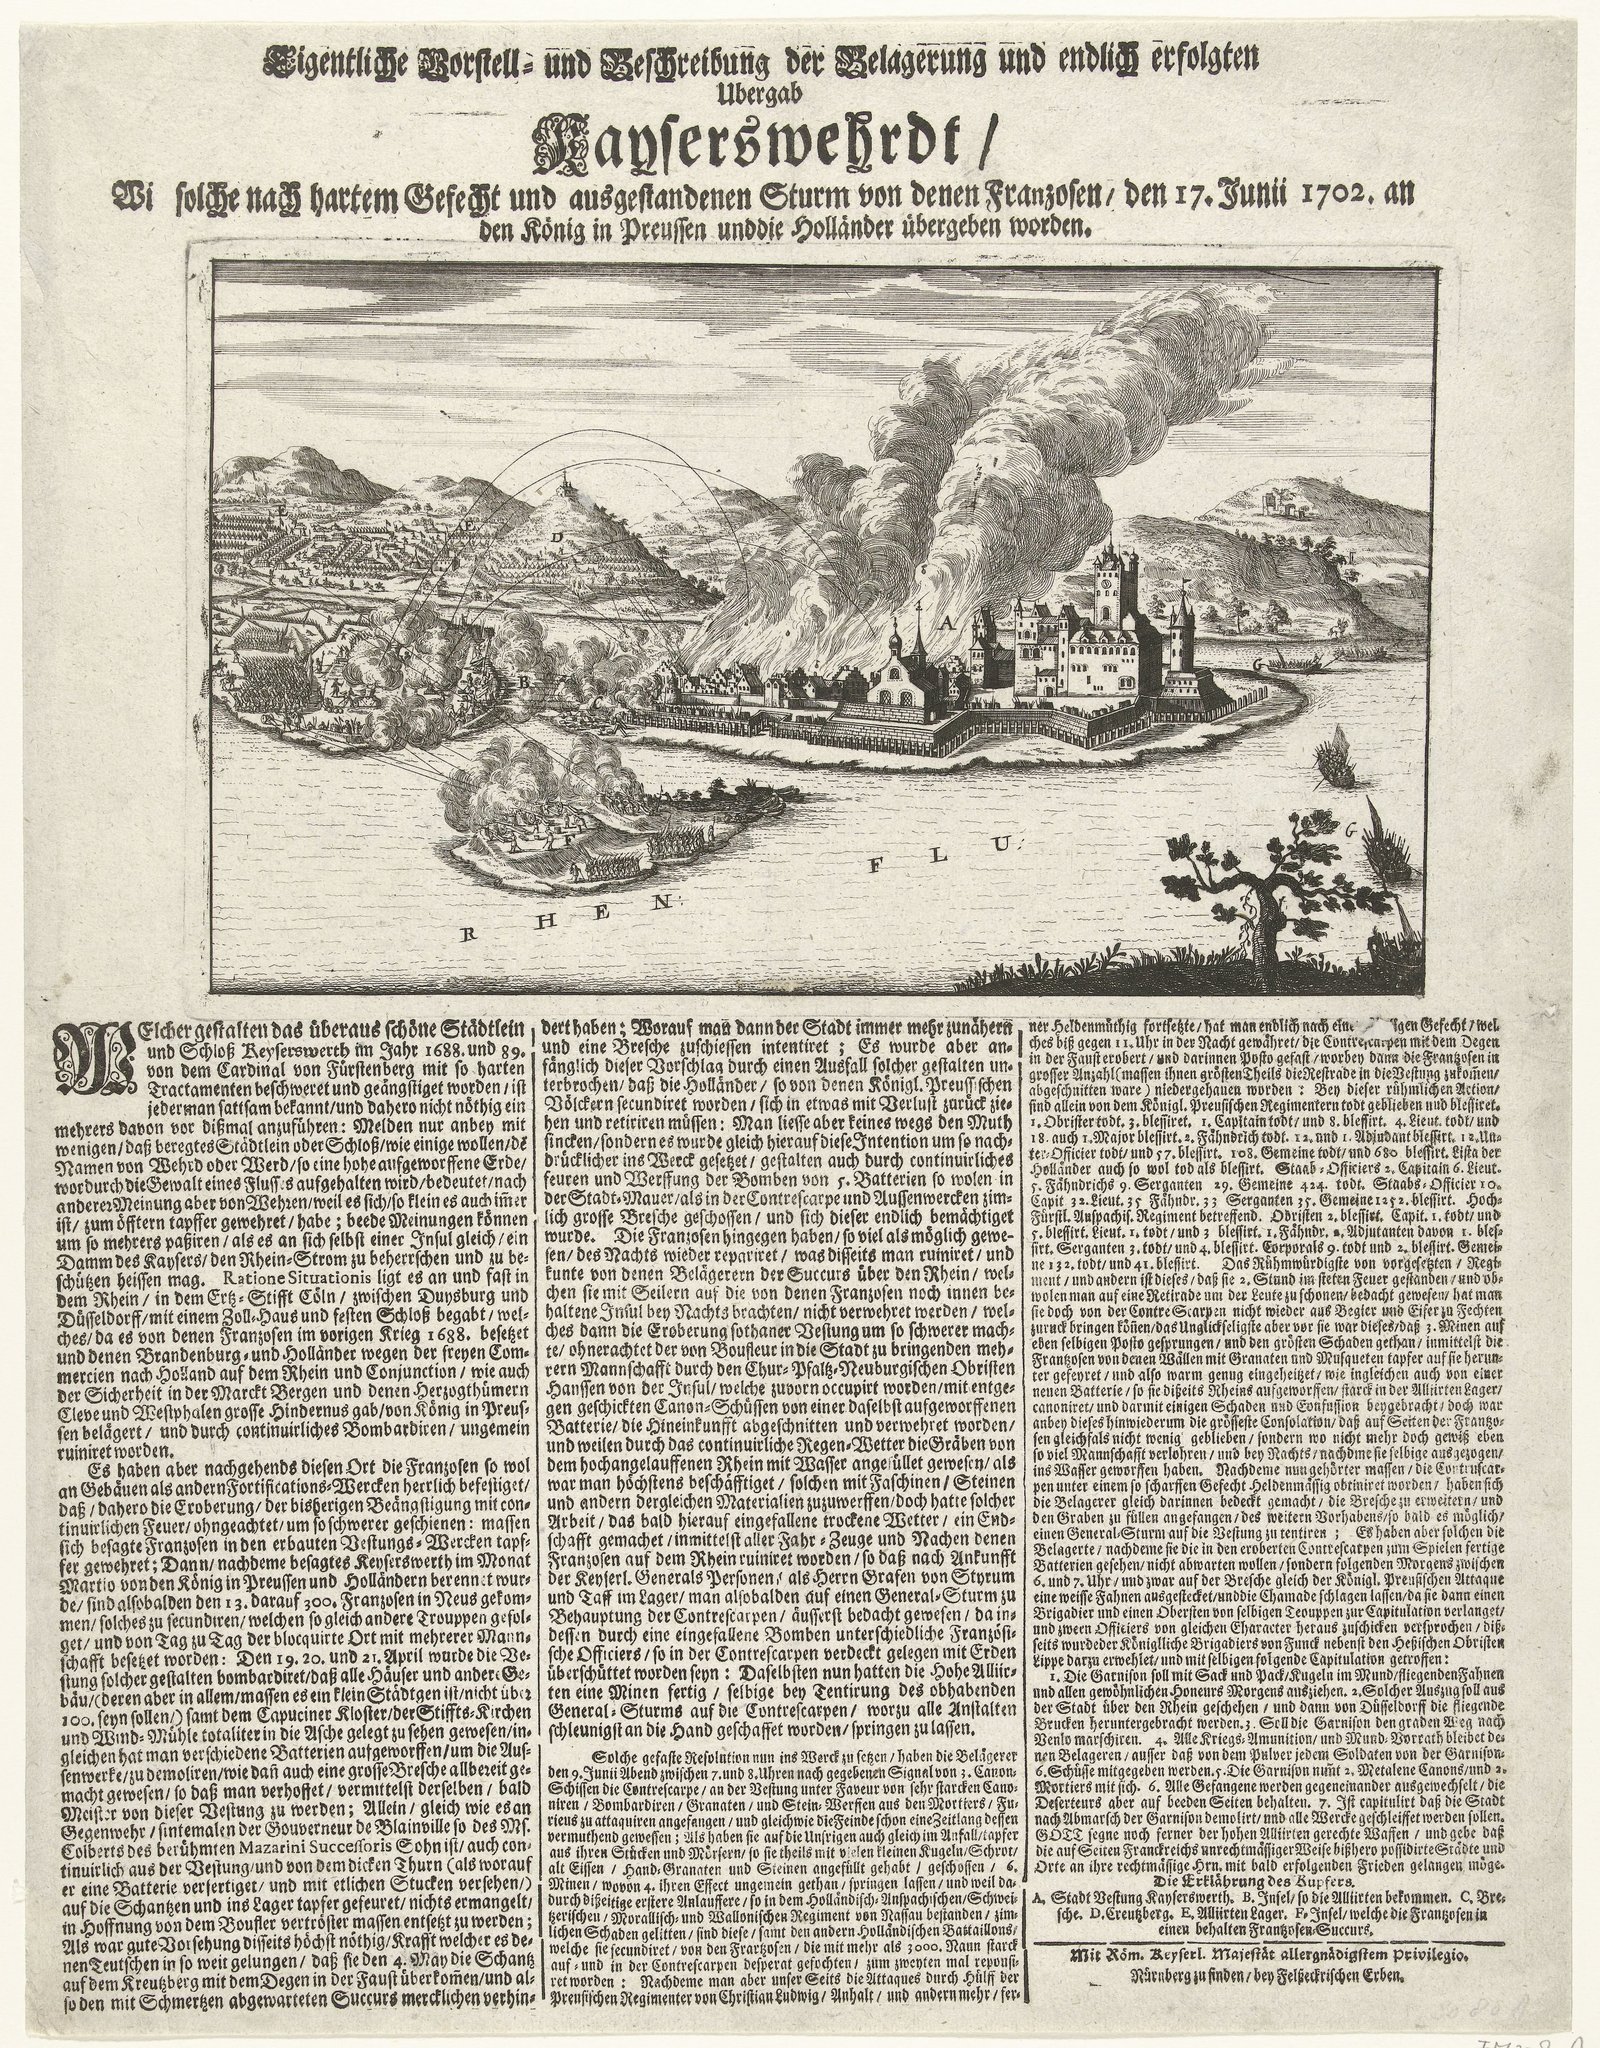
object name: print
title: Eigentliche Vorstell- und Beschreibung der Belagerung und endlich erfolgten Ubergab Kayserswehrdt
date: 1702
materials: paper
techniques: etching, letterpress printing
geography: germany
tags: siege, position war, maps of cities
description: Beschieting van Keizersweerd, belegerd door de geallieerden vanaf 18 april en ingenomen op 16 juni 1702. Op het blad onder de plaat een tekst in drie kolommen in het Duits.